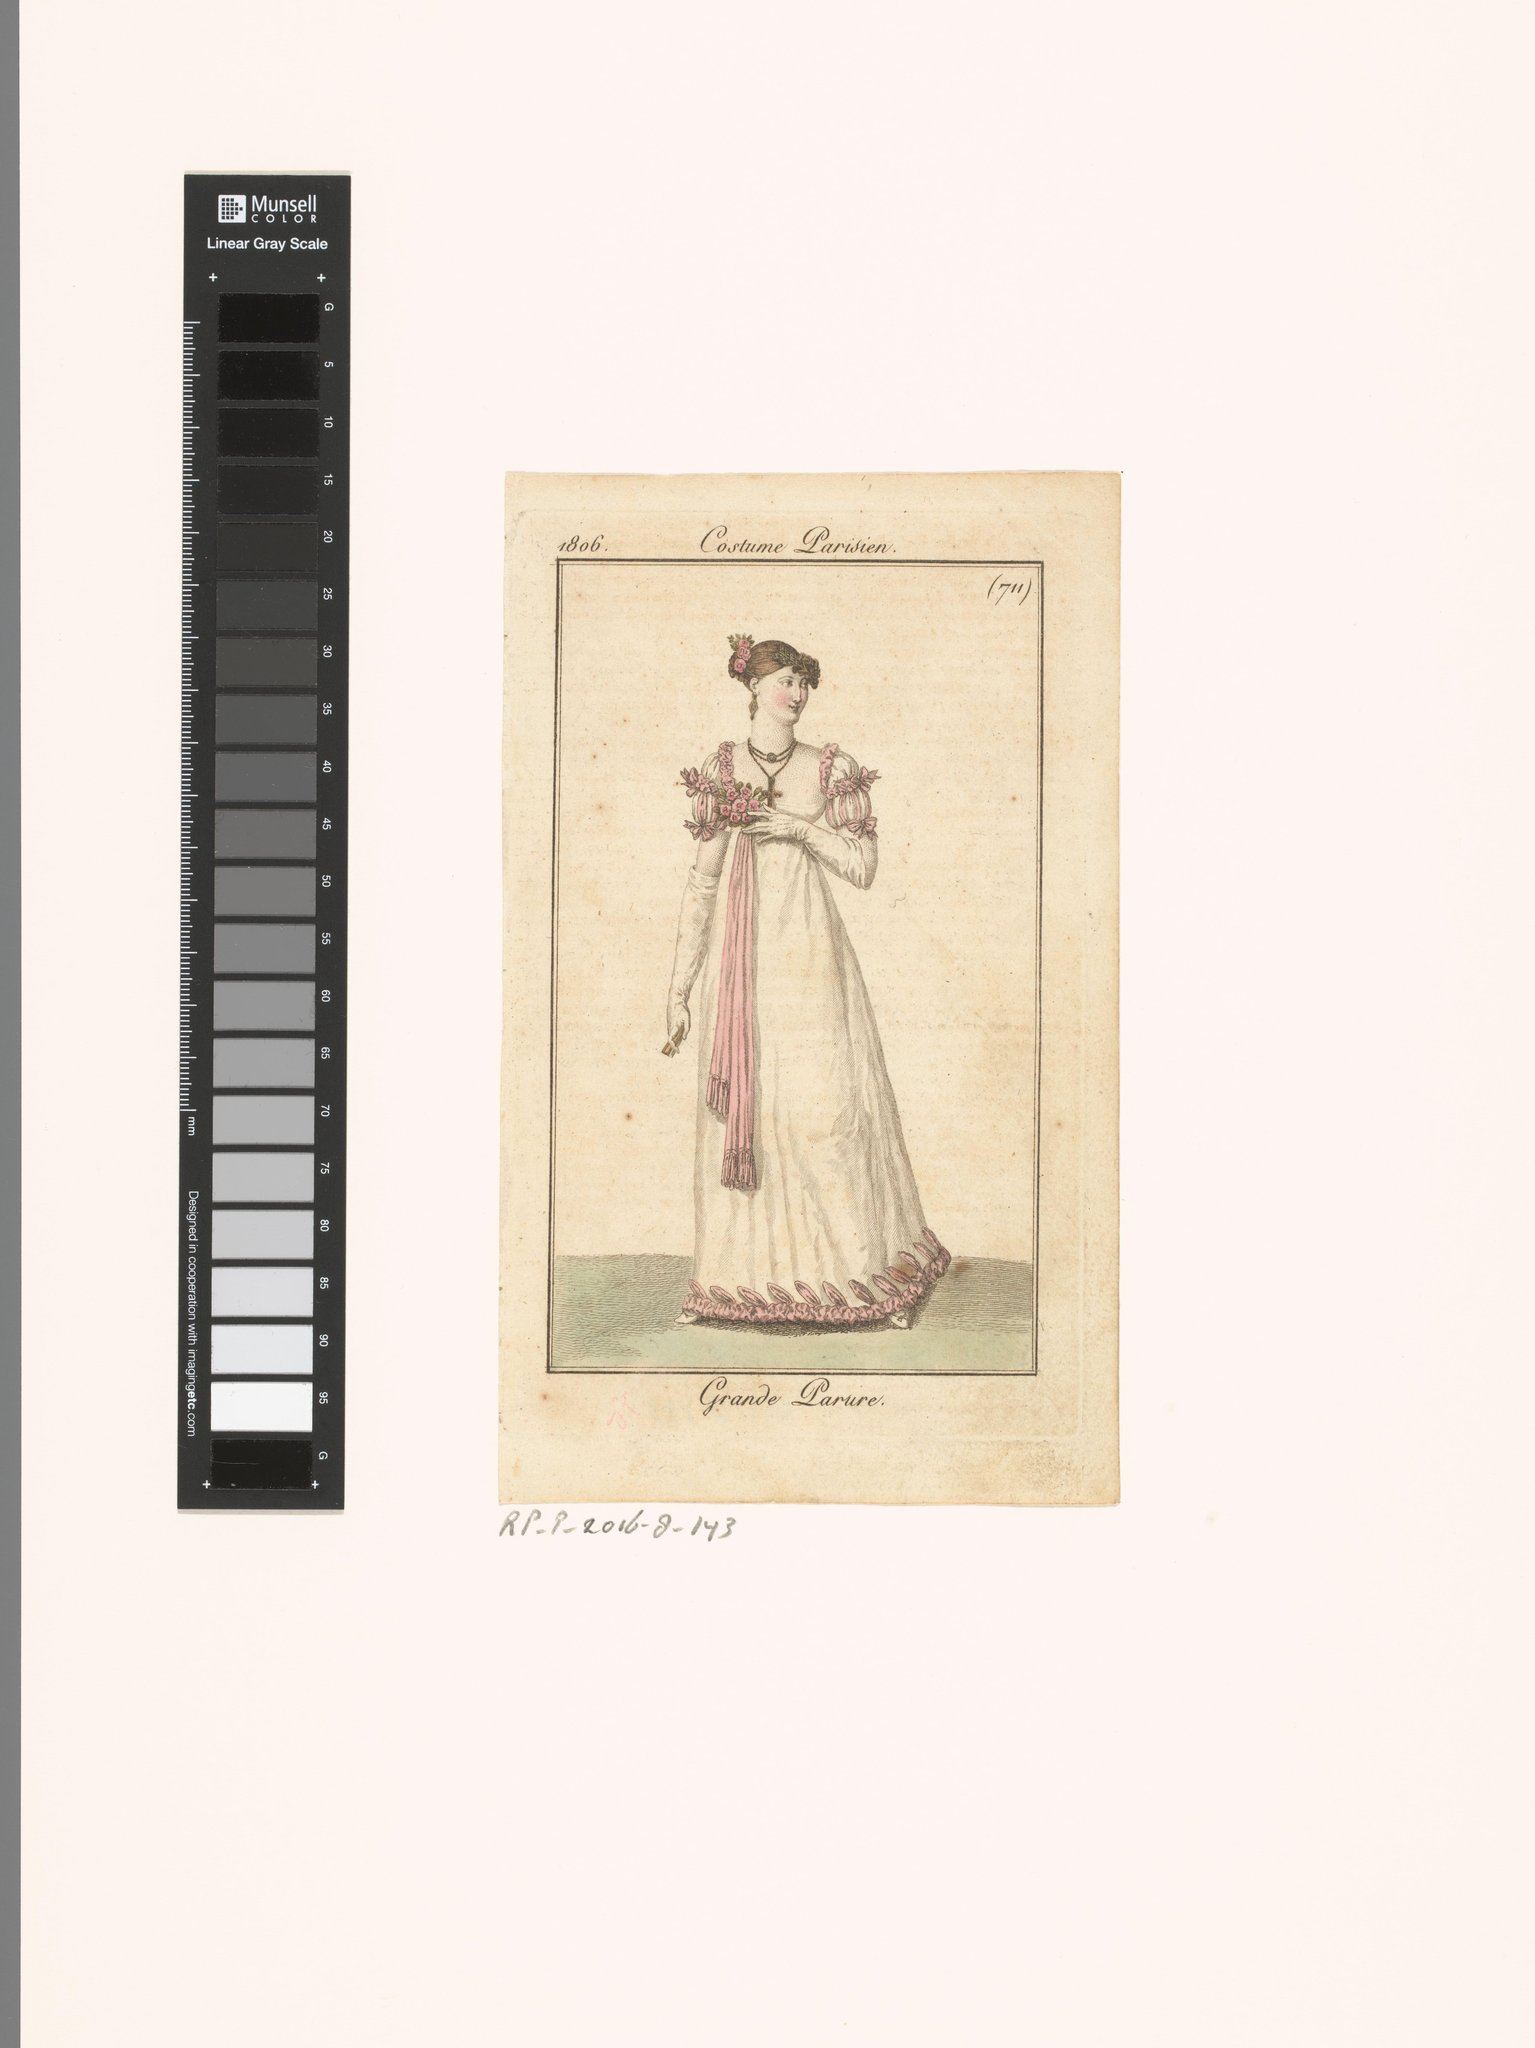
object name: fashion print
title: Journal des Dames et des modes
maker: Anonymous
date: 1806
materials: paper, ink, watercolor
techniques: etching, hand coloring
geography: france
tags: fashion plates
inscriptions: collector's mark: Lugt 2228